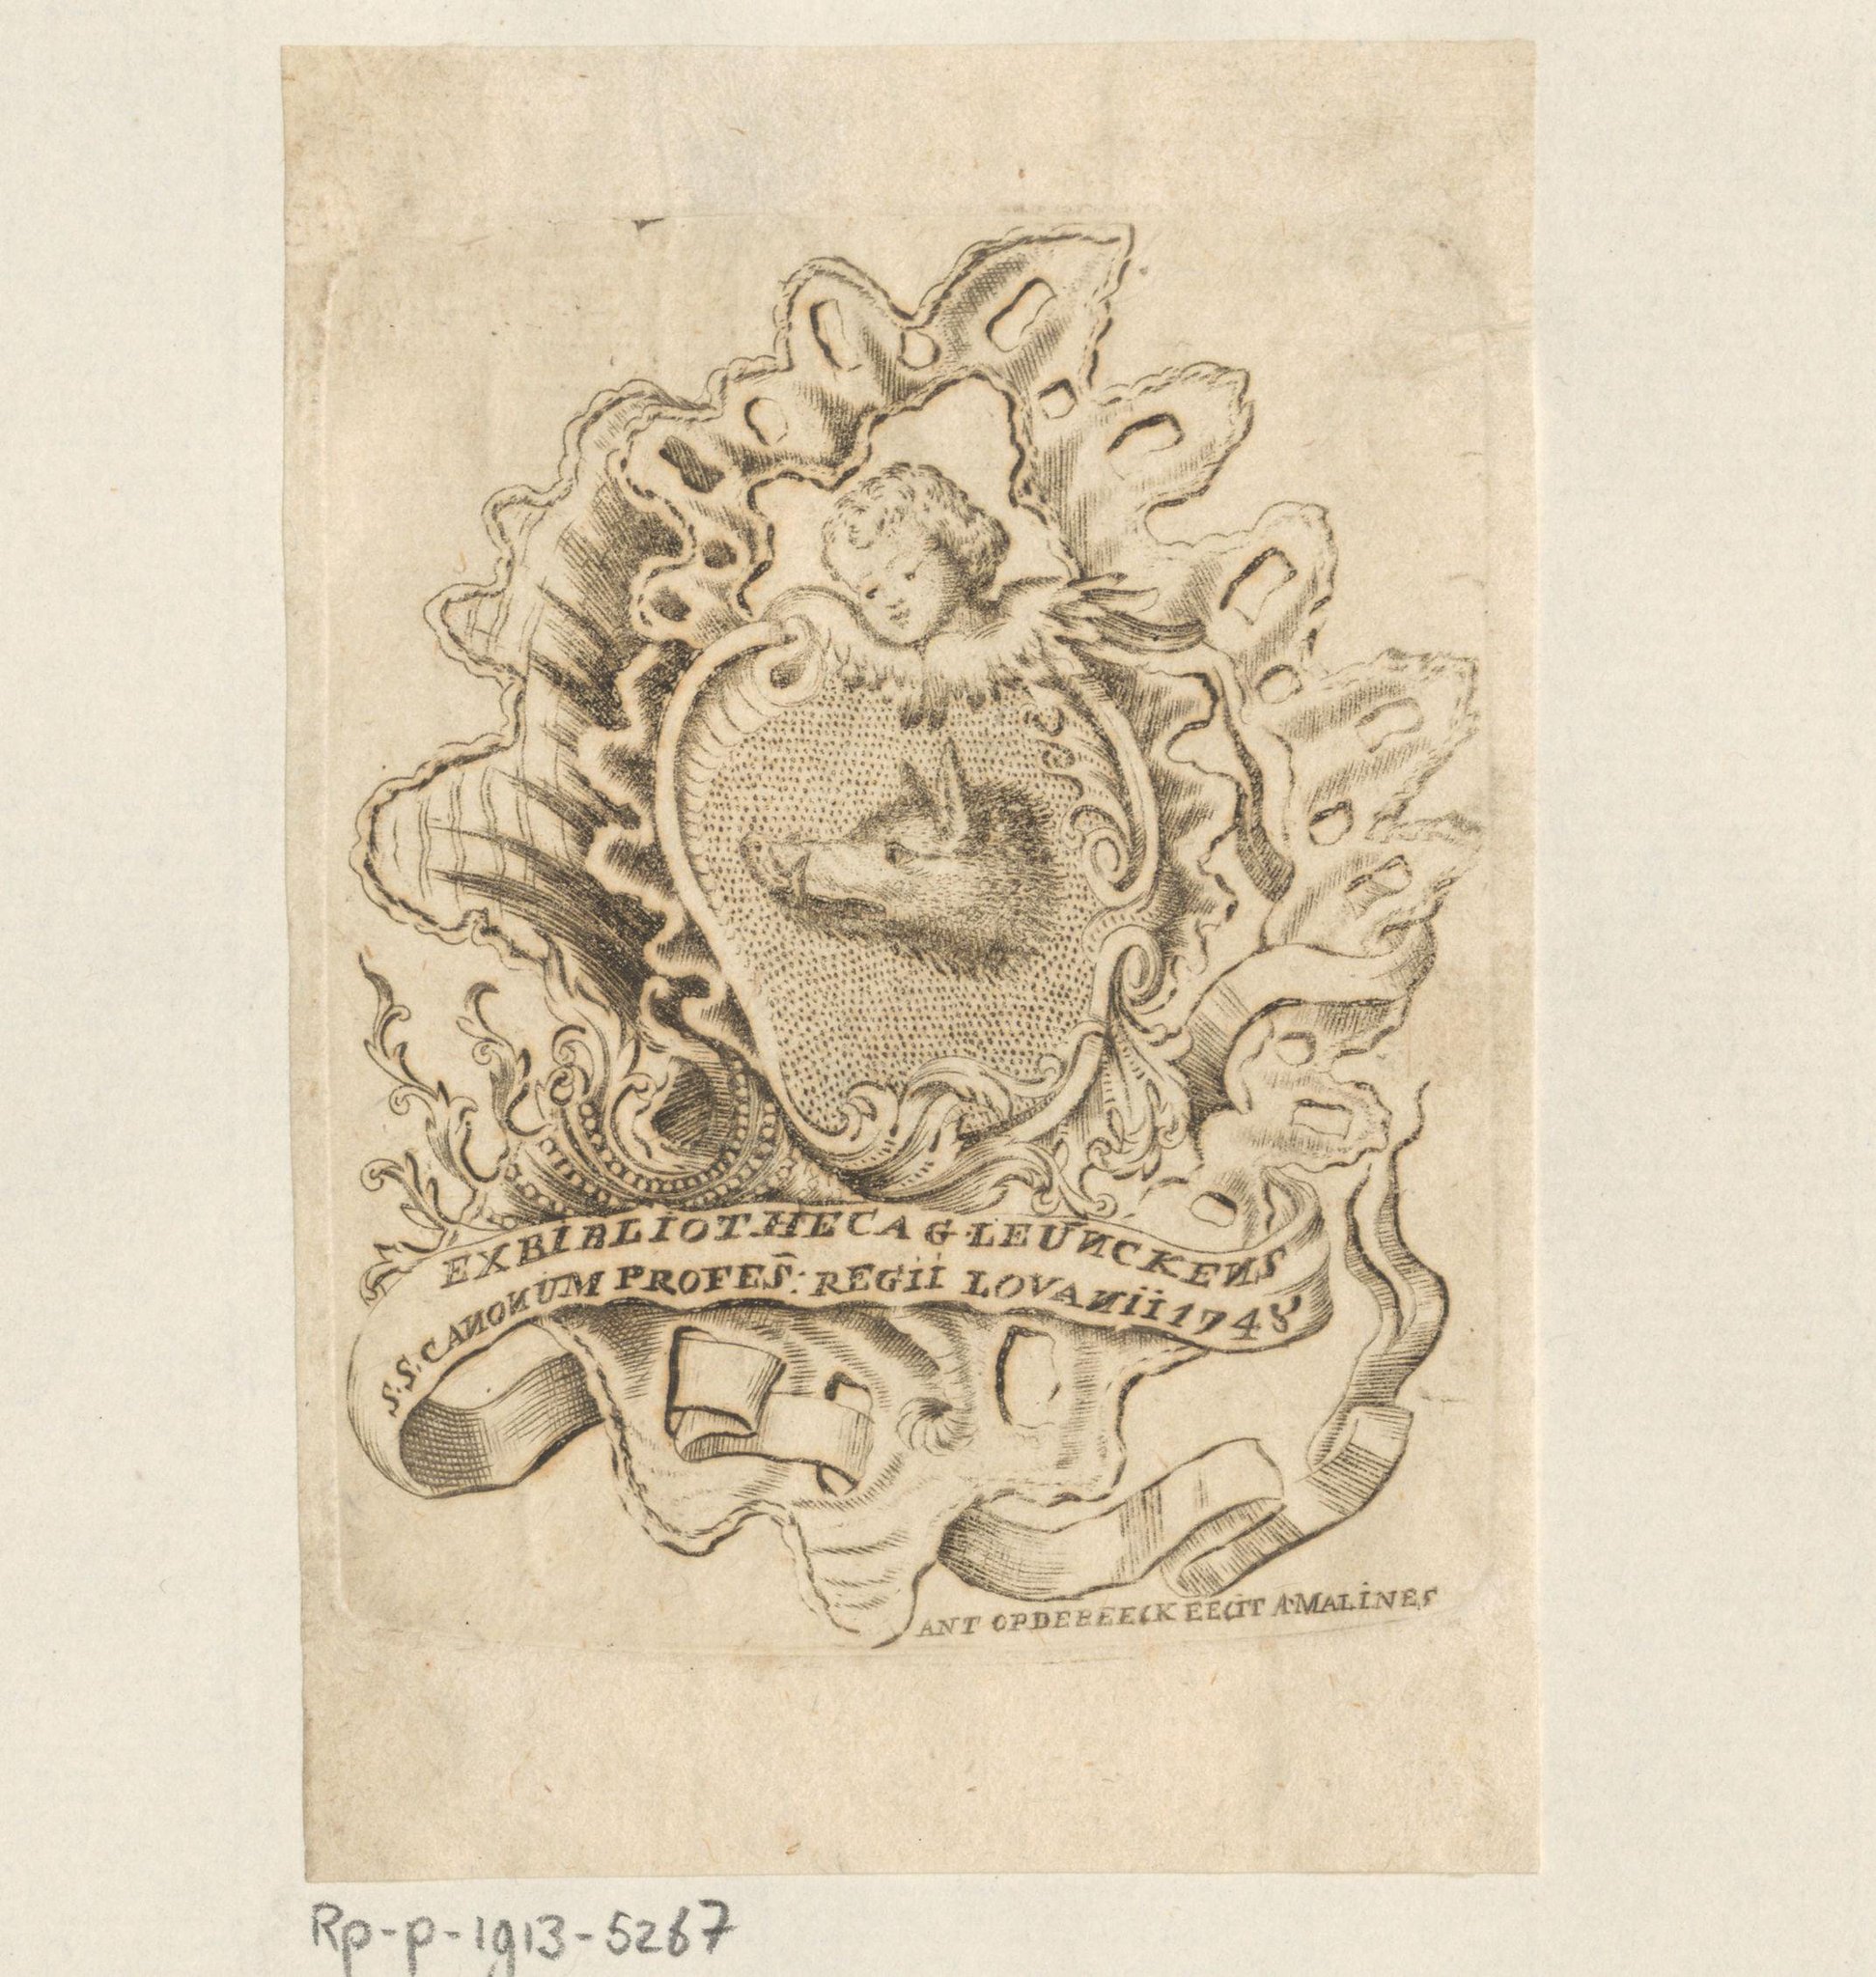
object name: bookplate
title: Ex libris van G. Leunckens S.S. Canonum Profes: Regii Lovanii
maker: antoine opdebeeck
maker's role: print maker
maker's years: 1709-1759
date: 1748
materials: paper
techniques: engraving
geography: mechelen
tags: armorial bearing, heraldry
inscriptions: collector's mark: Lugt 2760, collector's mark: Lugt 2233